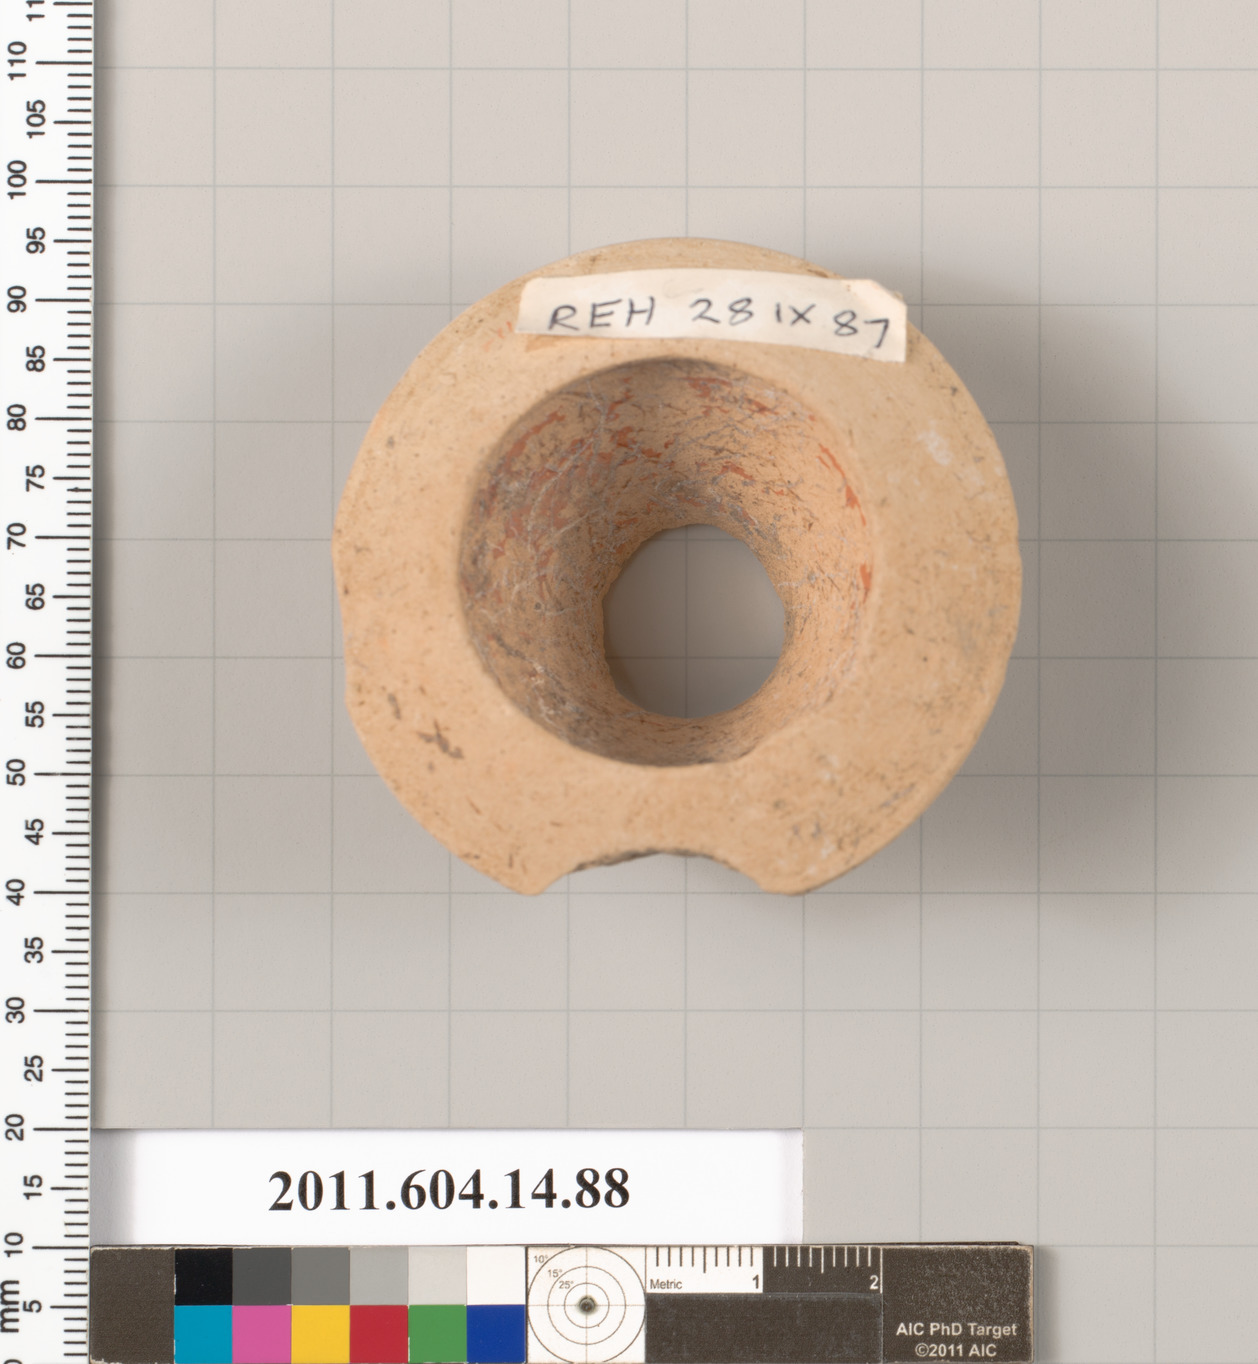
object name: vase fragment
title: Terracotta fragment of a vase?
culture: unknown fabric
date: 700-301 BCE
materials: terracotta